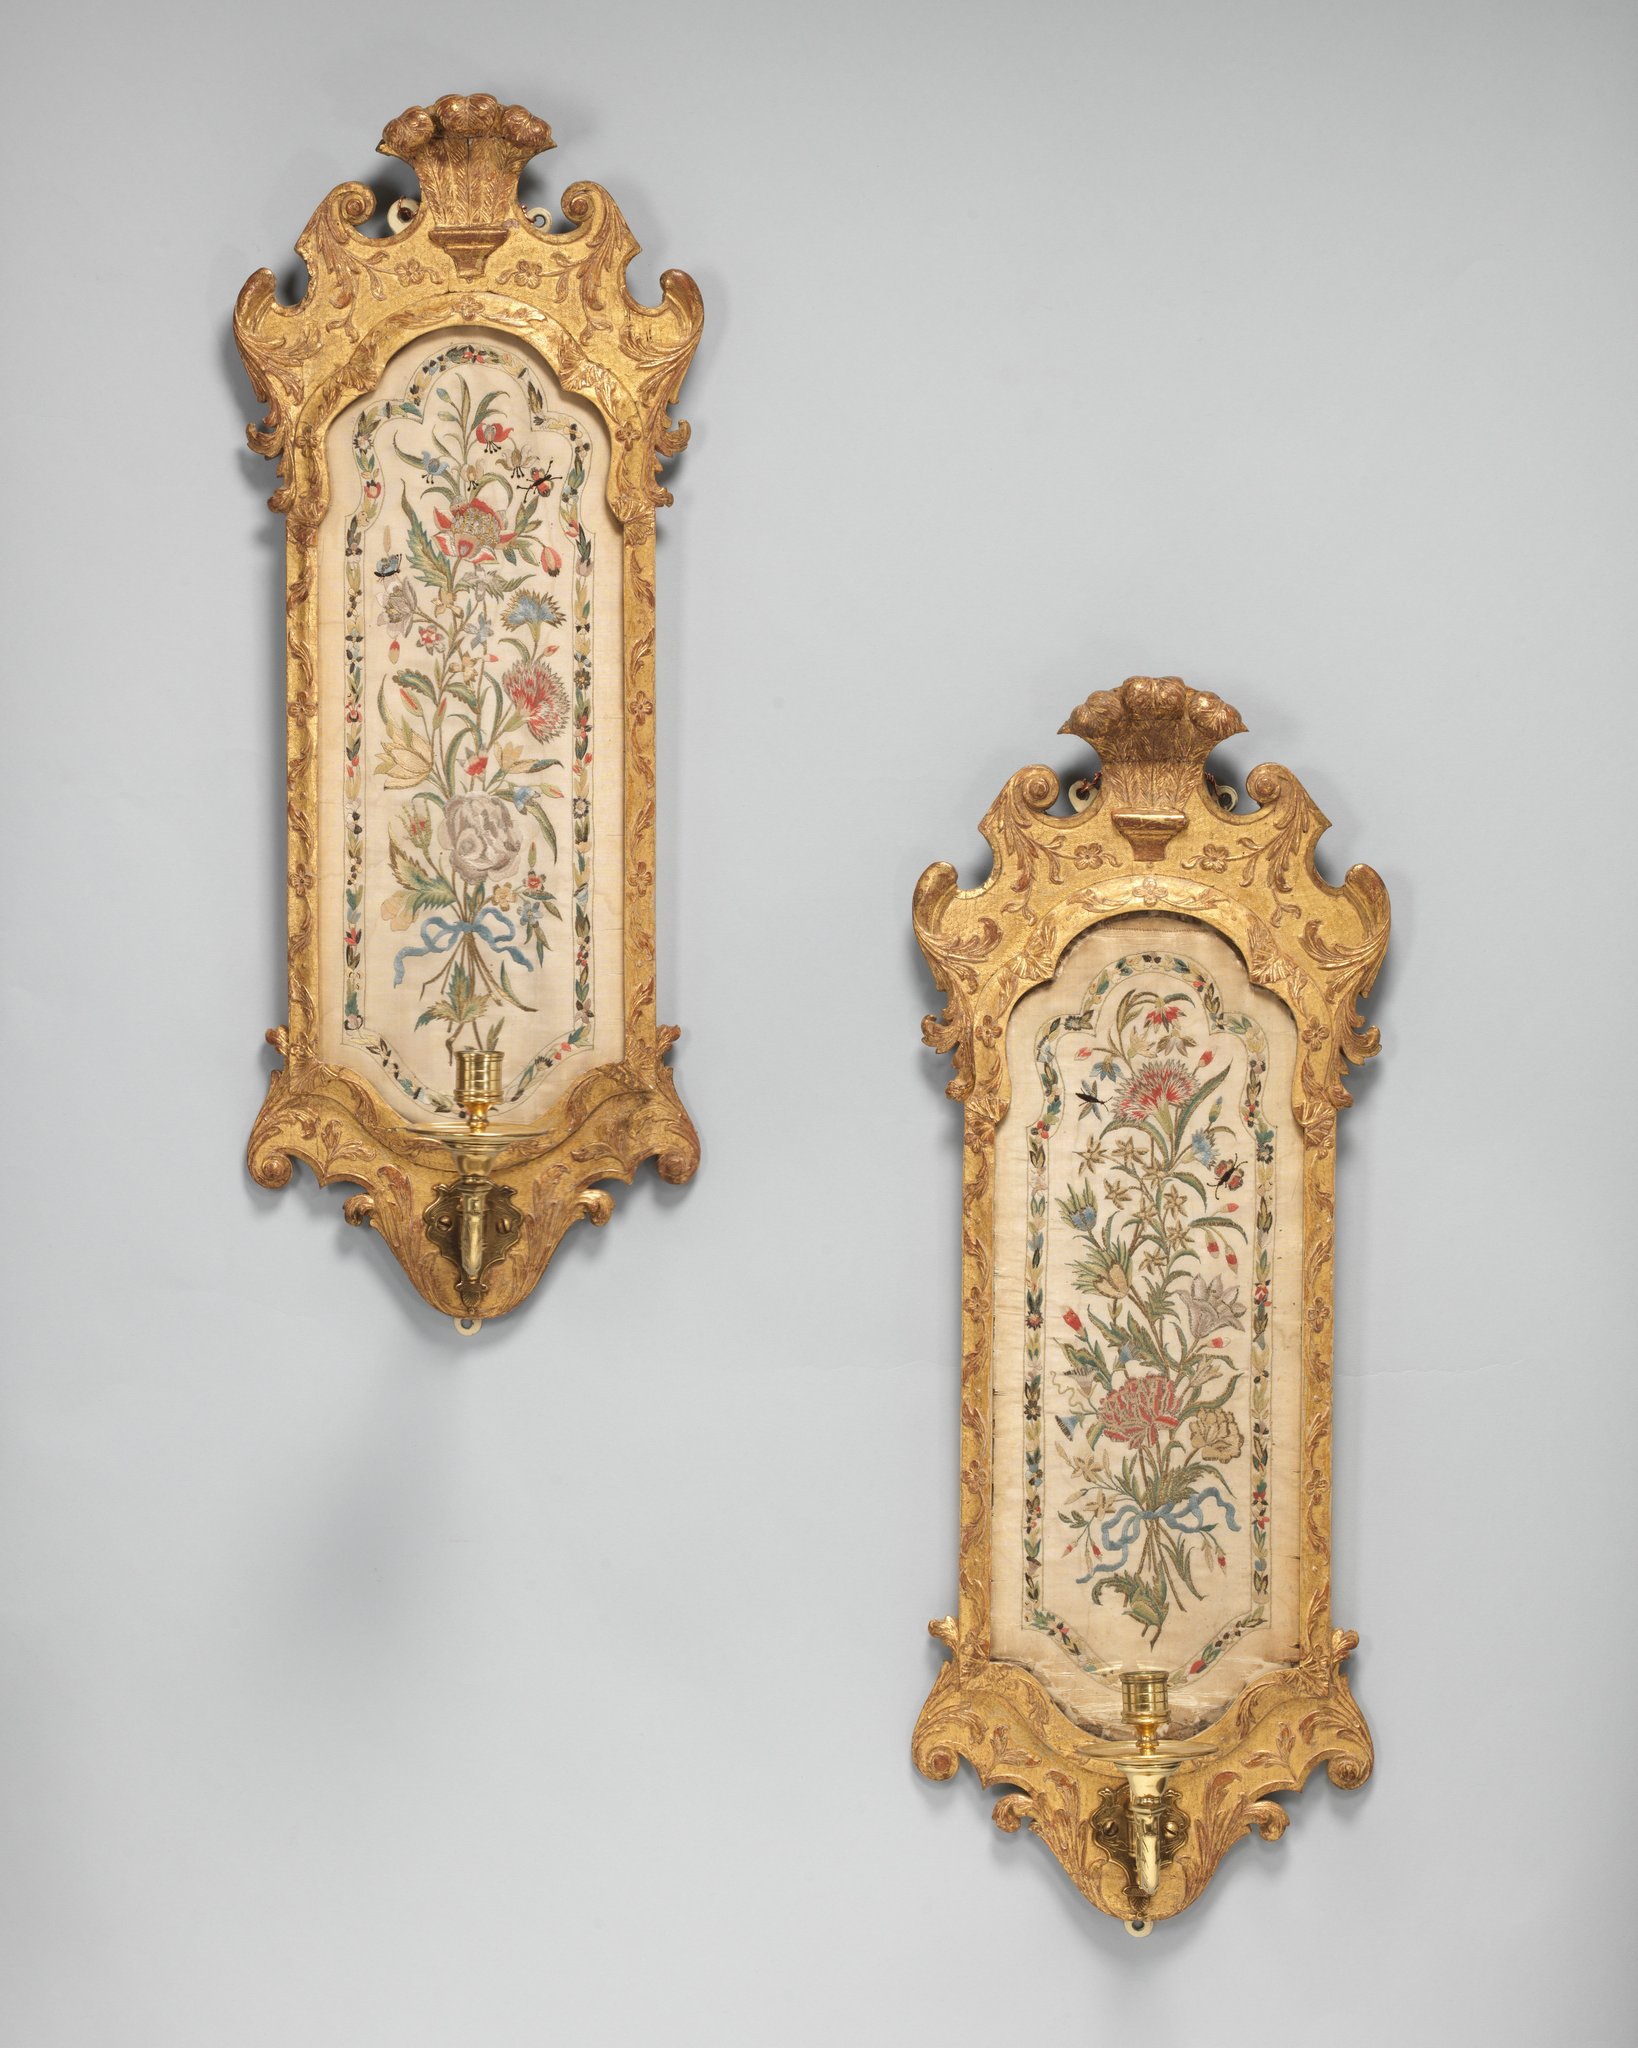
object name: wall sconce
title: Pair of wall sconces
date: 1730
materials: gesso, gilt, gilt bronze, wood, silk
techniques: embroidery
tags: flowers